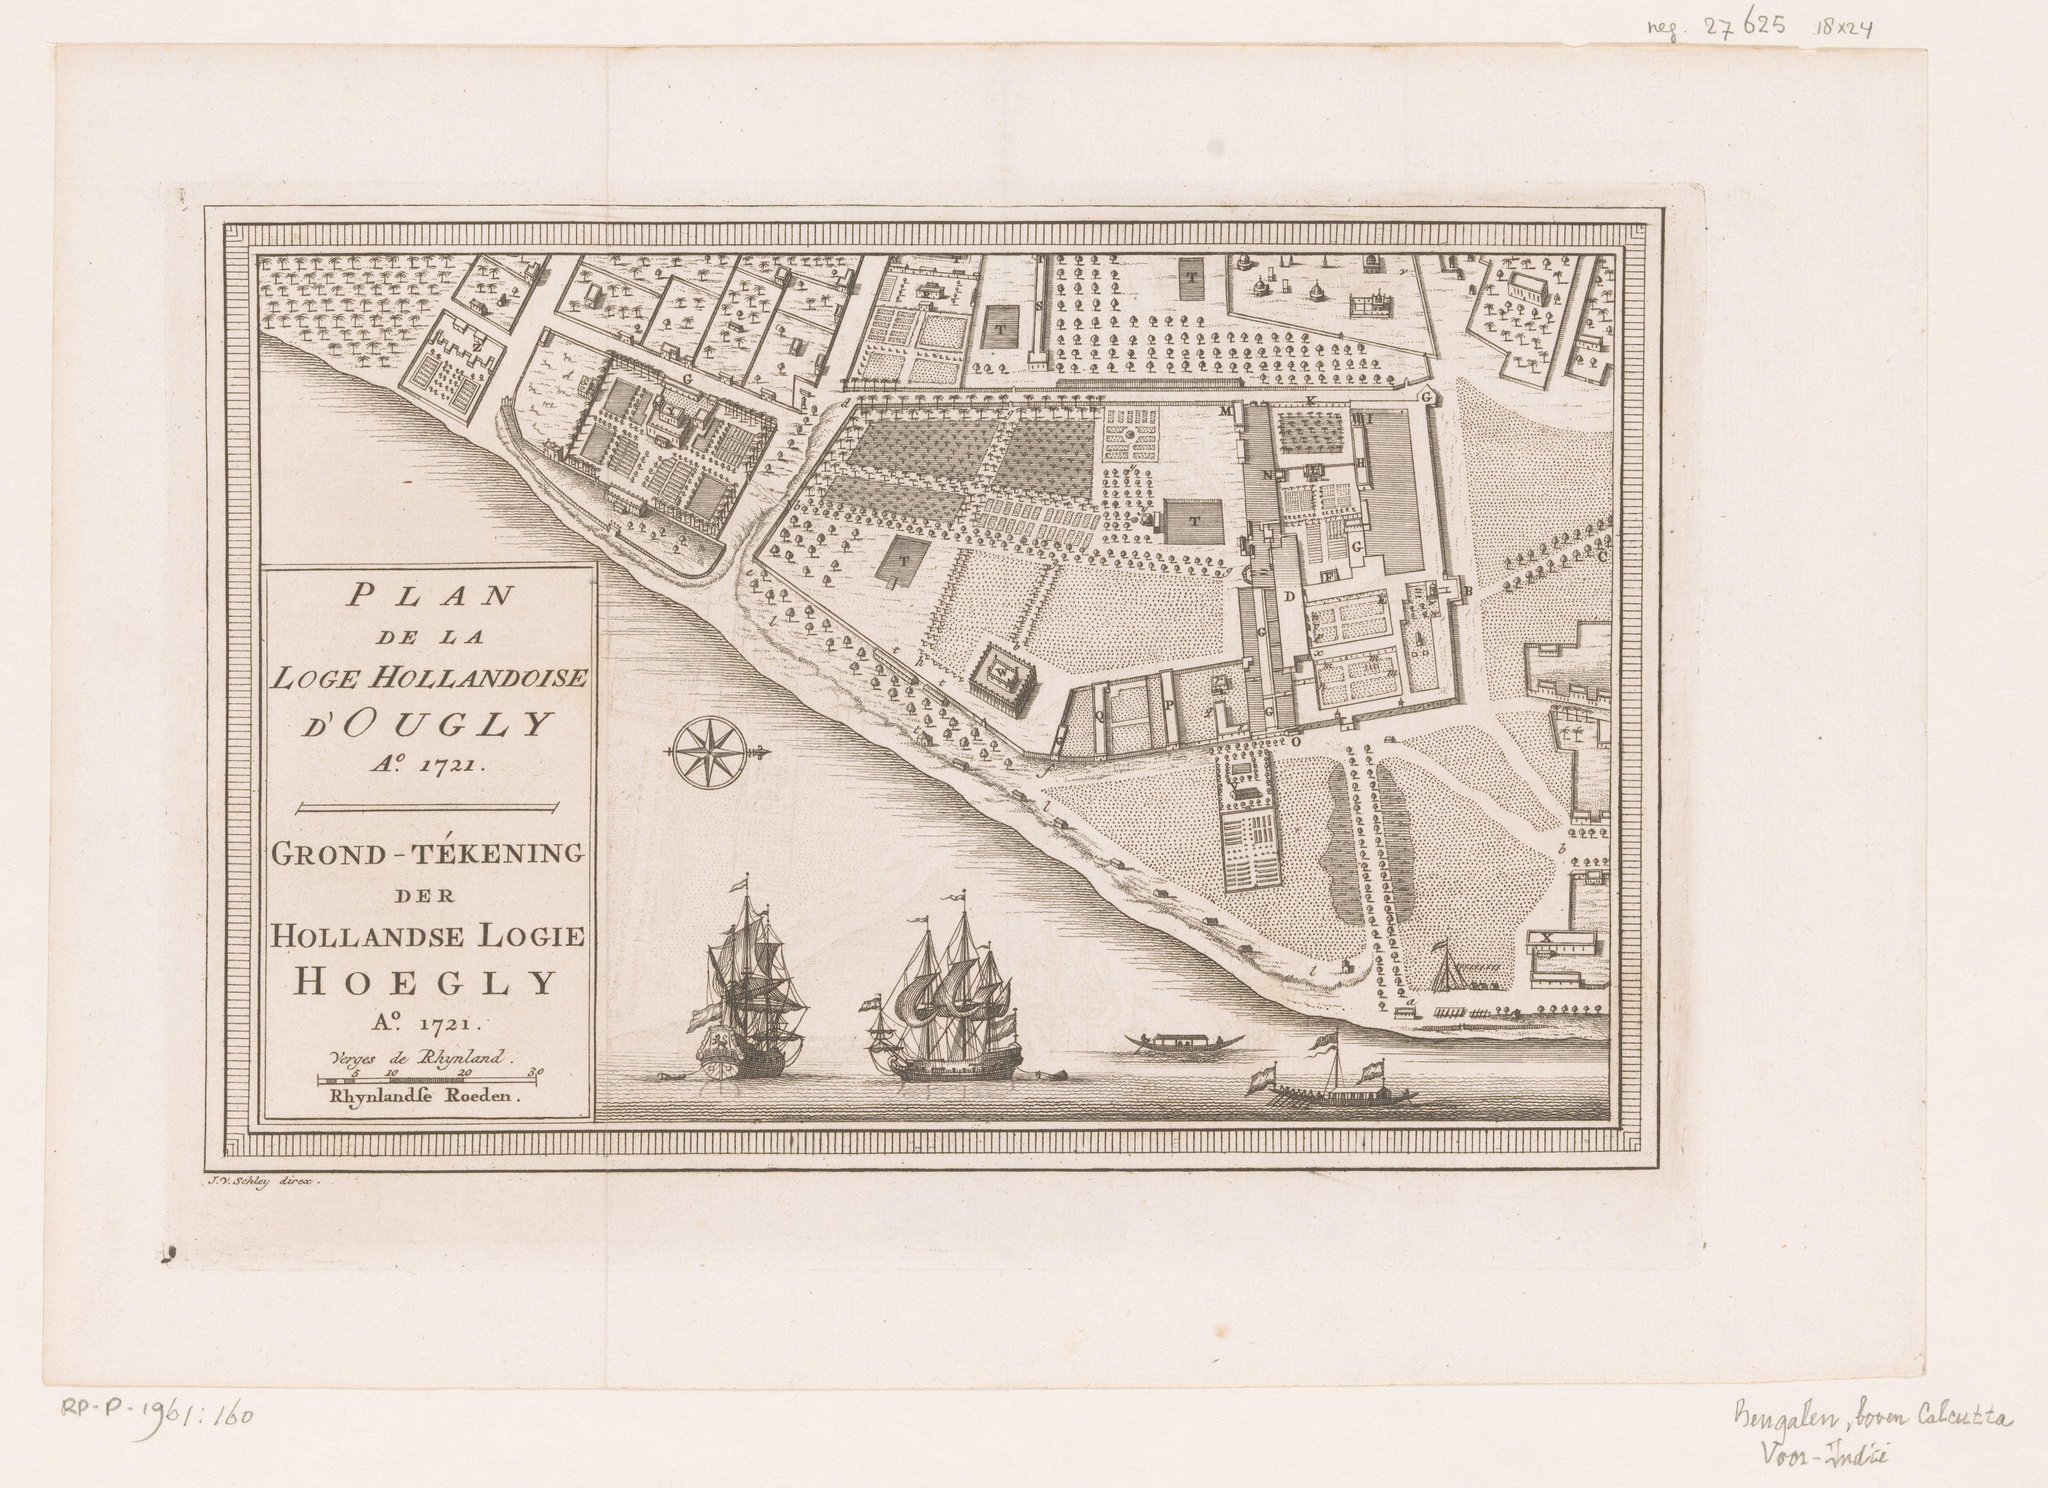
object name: area plan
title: Plan de la loge Hollandoise d'Ougly ao. 1721 / Grond-tékening der Hollandse loge Hoegly ao. 1721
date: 1767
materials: paper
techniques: engraving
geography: amsterdam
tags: maps of cities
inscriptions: collector's mark: Lugt 2228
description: Oost georiënteerde plattegrond van de Hollandse loge Hougly, bij het tegenwoordige Hooghly-Chinsurah. Op zee zijn twee sloepen en twee driemasters afgebeeld. Onder de titels linksonder een schaalstok in Rijnlandse roeden.